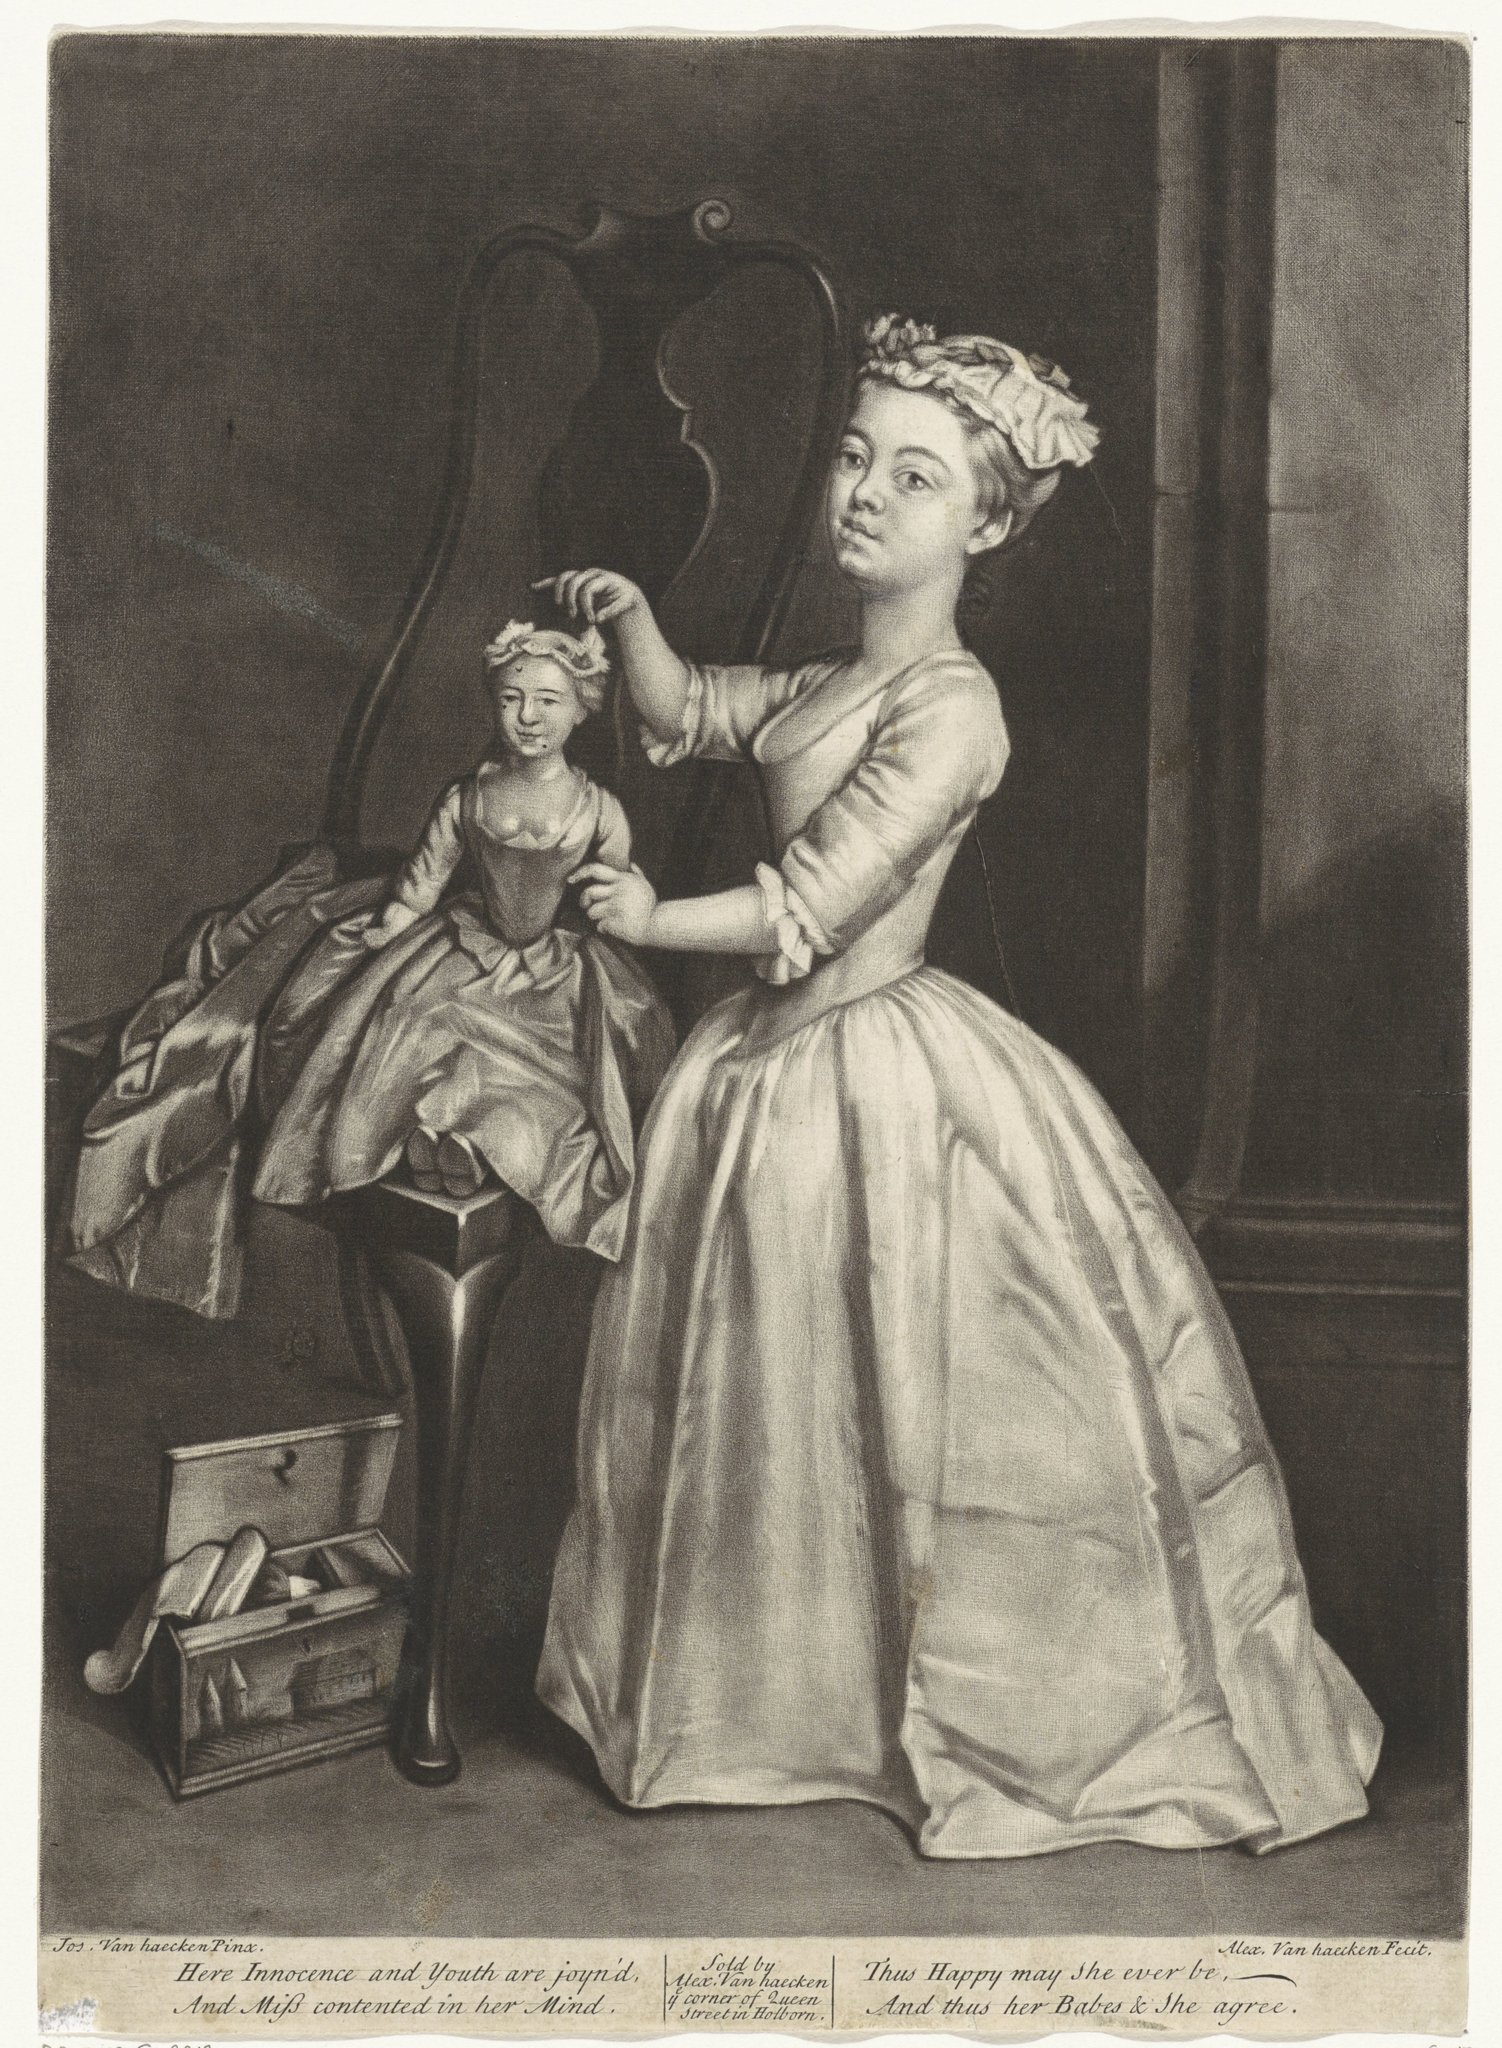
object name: print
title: Meisje met een pop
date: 1735-1757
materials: paper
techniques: engraving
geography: england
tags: (playing with) dolls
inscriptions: collector's mark: Lugt 2228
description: Een meisje staat naast een stoel waar haar pop op zit. Ze plukt aan het kapje van de pop en houdt met haar andere hand de arm van de pop vast.